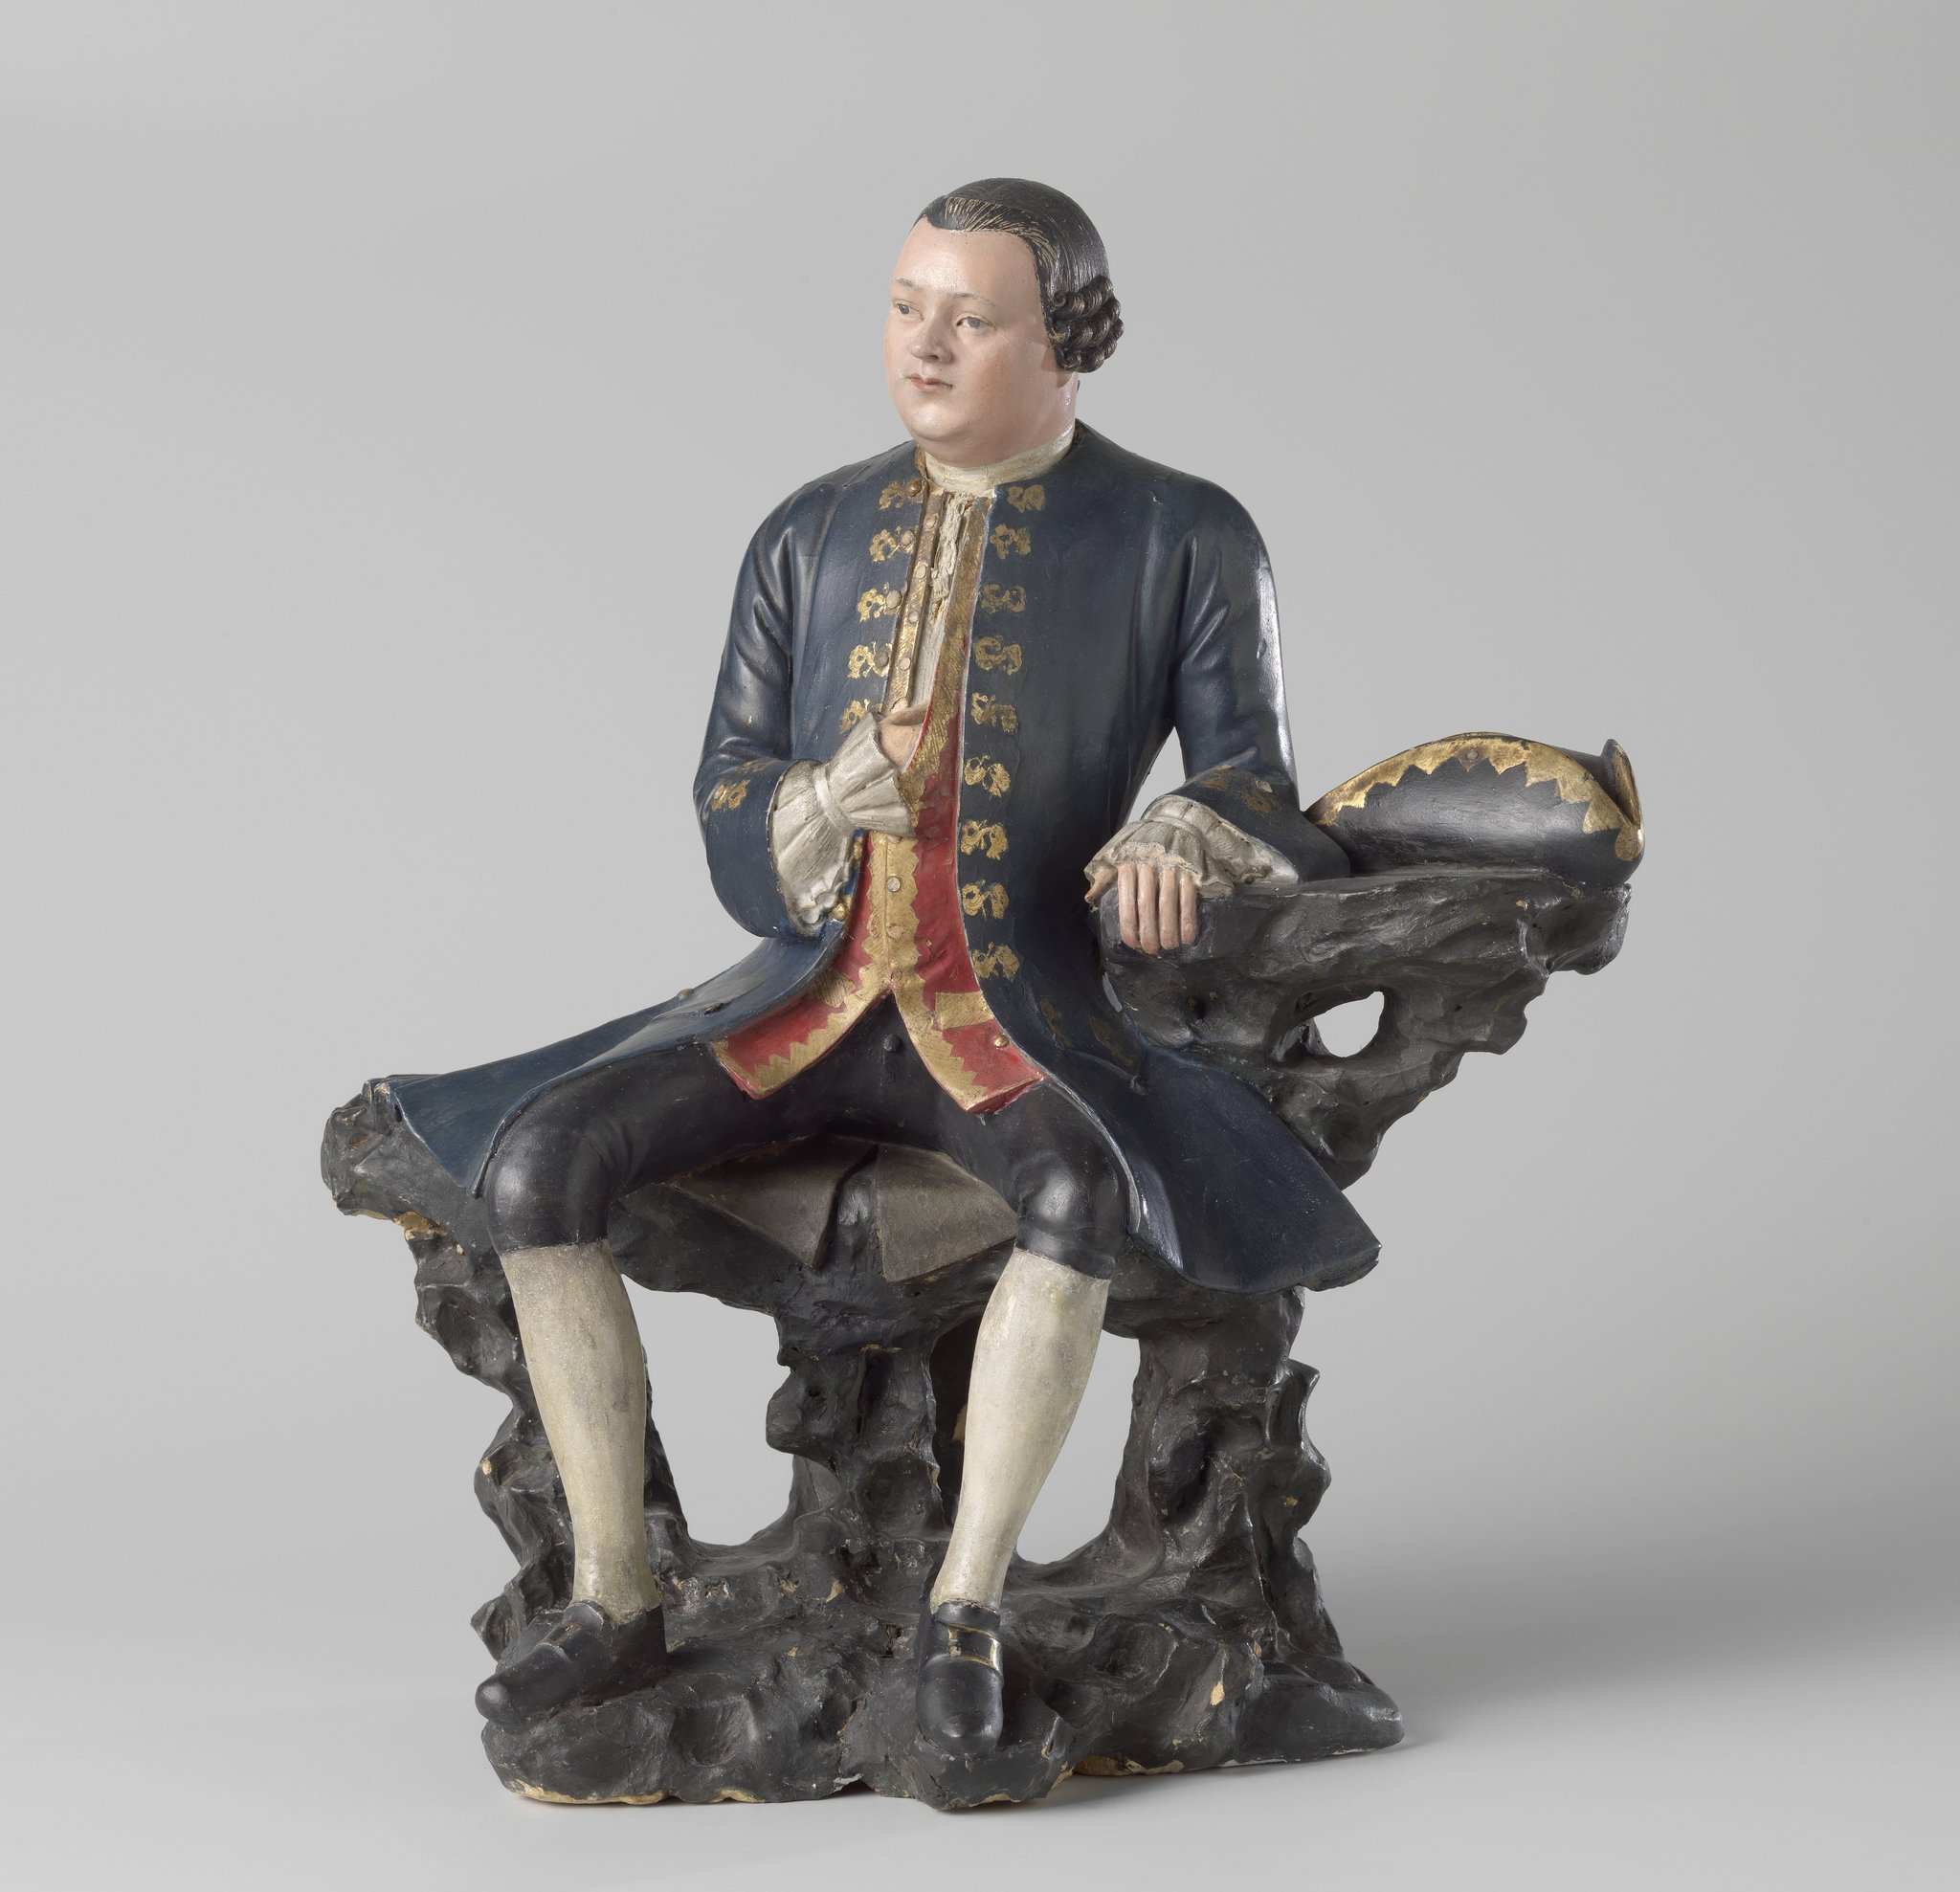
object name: figure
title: Portrait of Andreas Everardus van Braam Houckgeest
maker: chitqua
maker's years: 1740-1796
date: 1770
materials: clay, oil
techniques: polychromy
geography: guangdong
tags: amsterdam, sitting figure, historical persons, head-gear: hat (+ men's clothes)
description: Van Braam Houckgeest was director of the Dutch East India Company (VOC) trading post in the southern Chinese port of Canton from 1790 to 1795. He possibly ordered this figure of himself during one of his earlier journeys through China. The Chinese sculptor Chitqua specialized in such clay portraits, usually of foreigners. Comparable likenesses of other Dutch merchants and captains of VOC ships are also known.